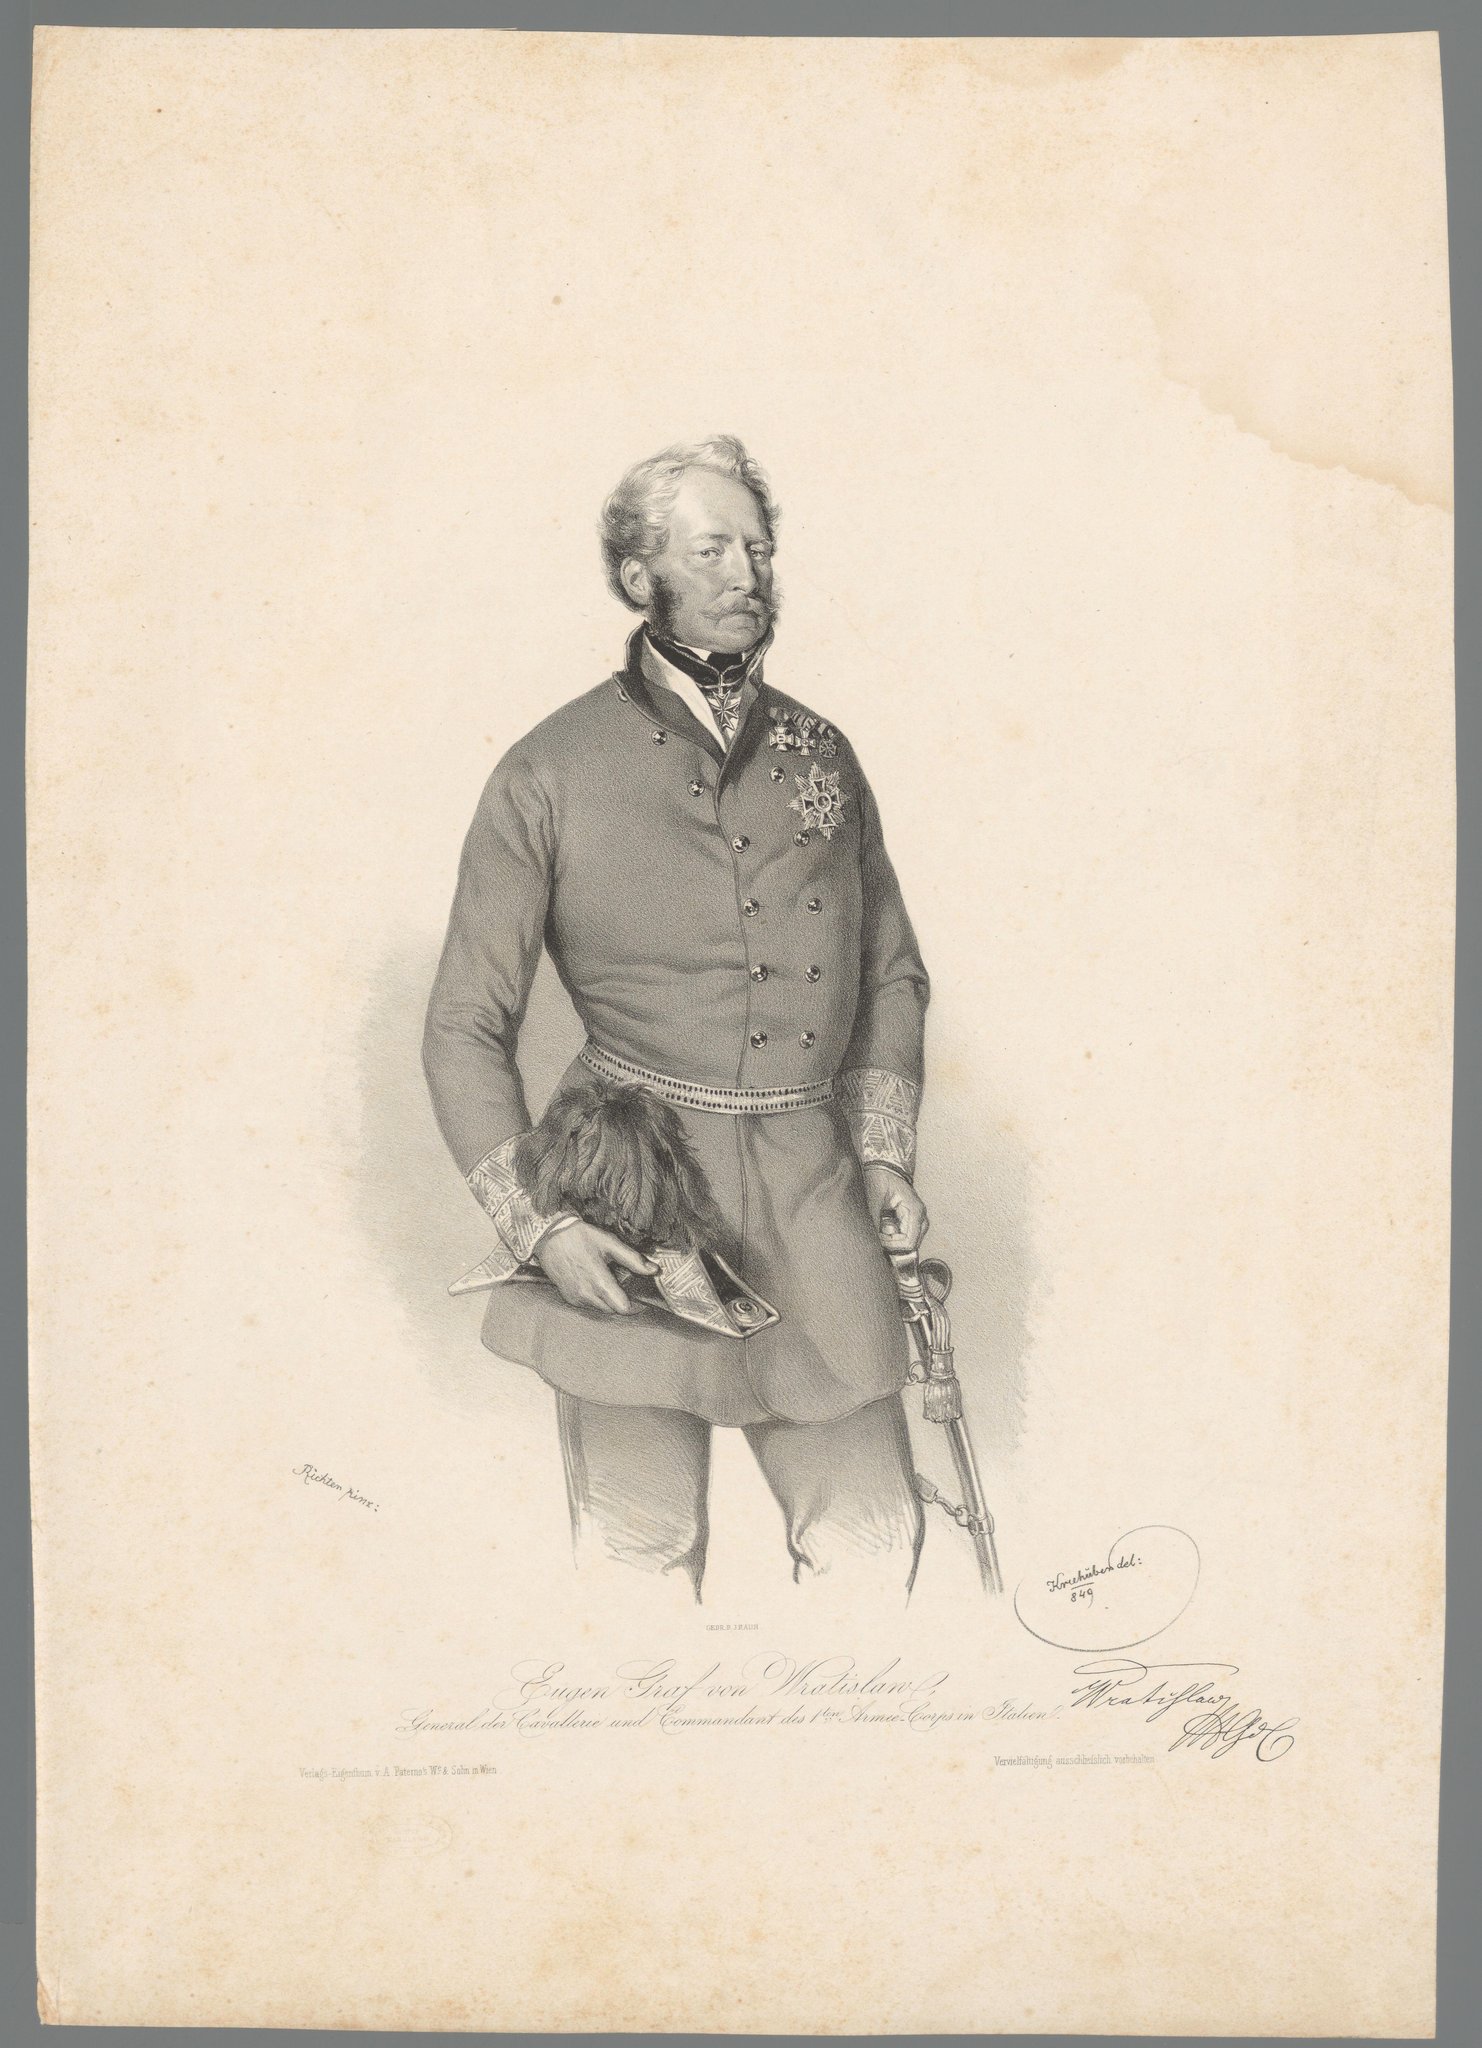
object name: print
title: Portret van Eugen Wratislaw von Mitrowitz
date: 1849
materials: paper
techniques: lithograph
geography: vienna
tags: vienna, commander-in-chief, general, marshal, historical persons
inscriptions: collector's mark: Lugt 2228, check stamp: ‘A. Paterno's Wtwe & Sohn Kunsthandlung in Wien’